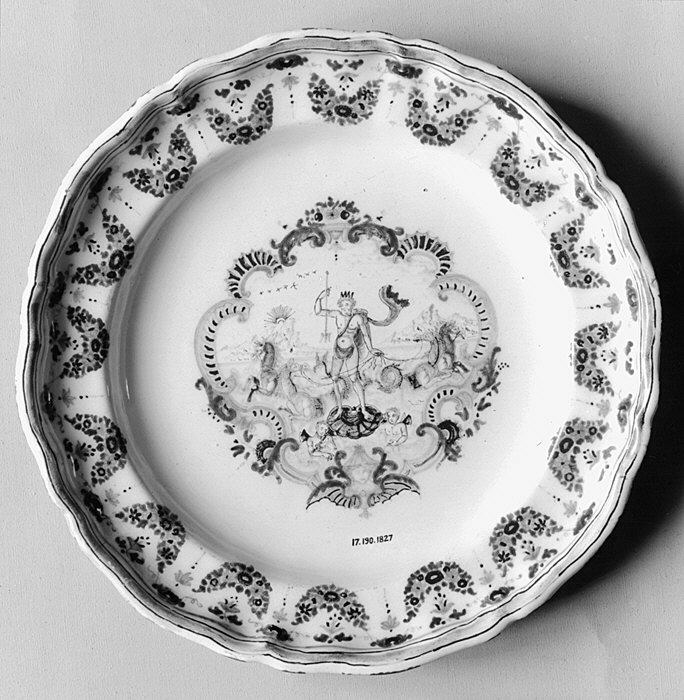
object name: plate or tray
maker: olérys factory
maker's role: manufactory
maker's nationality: french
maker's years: 1738-1838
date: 1745-1750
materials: faience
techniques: glazing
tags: men,horses